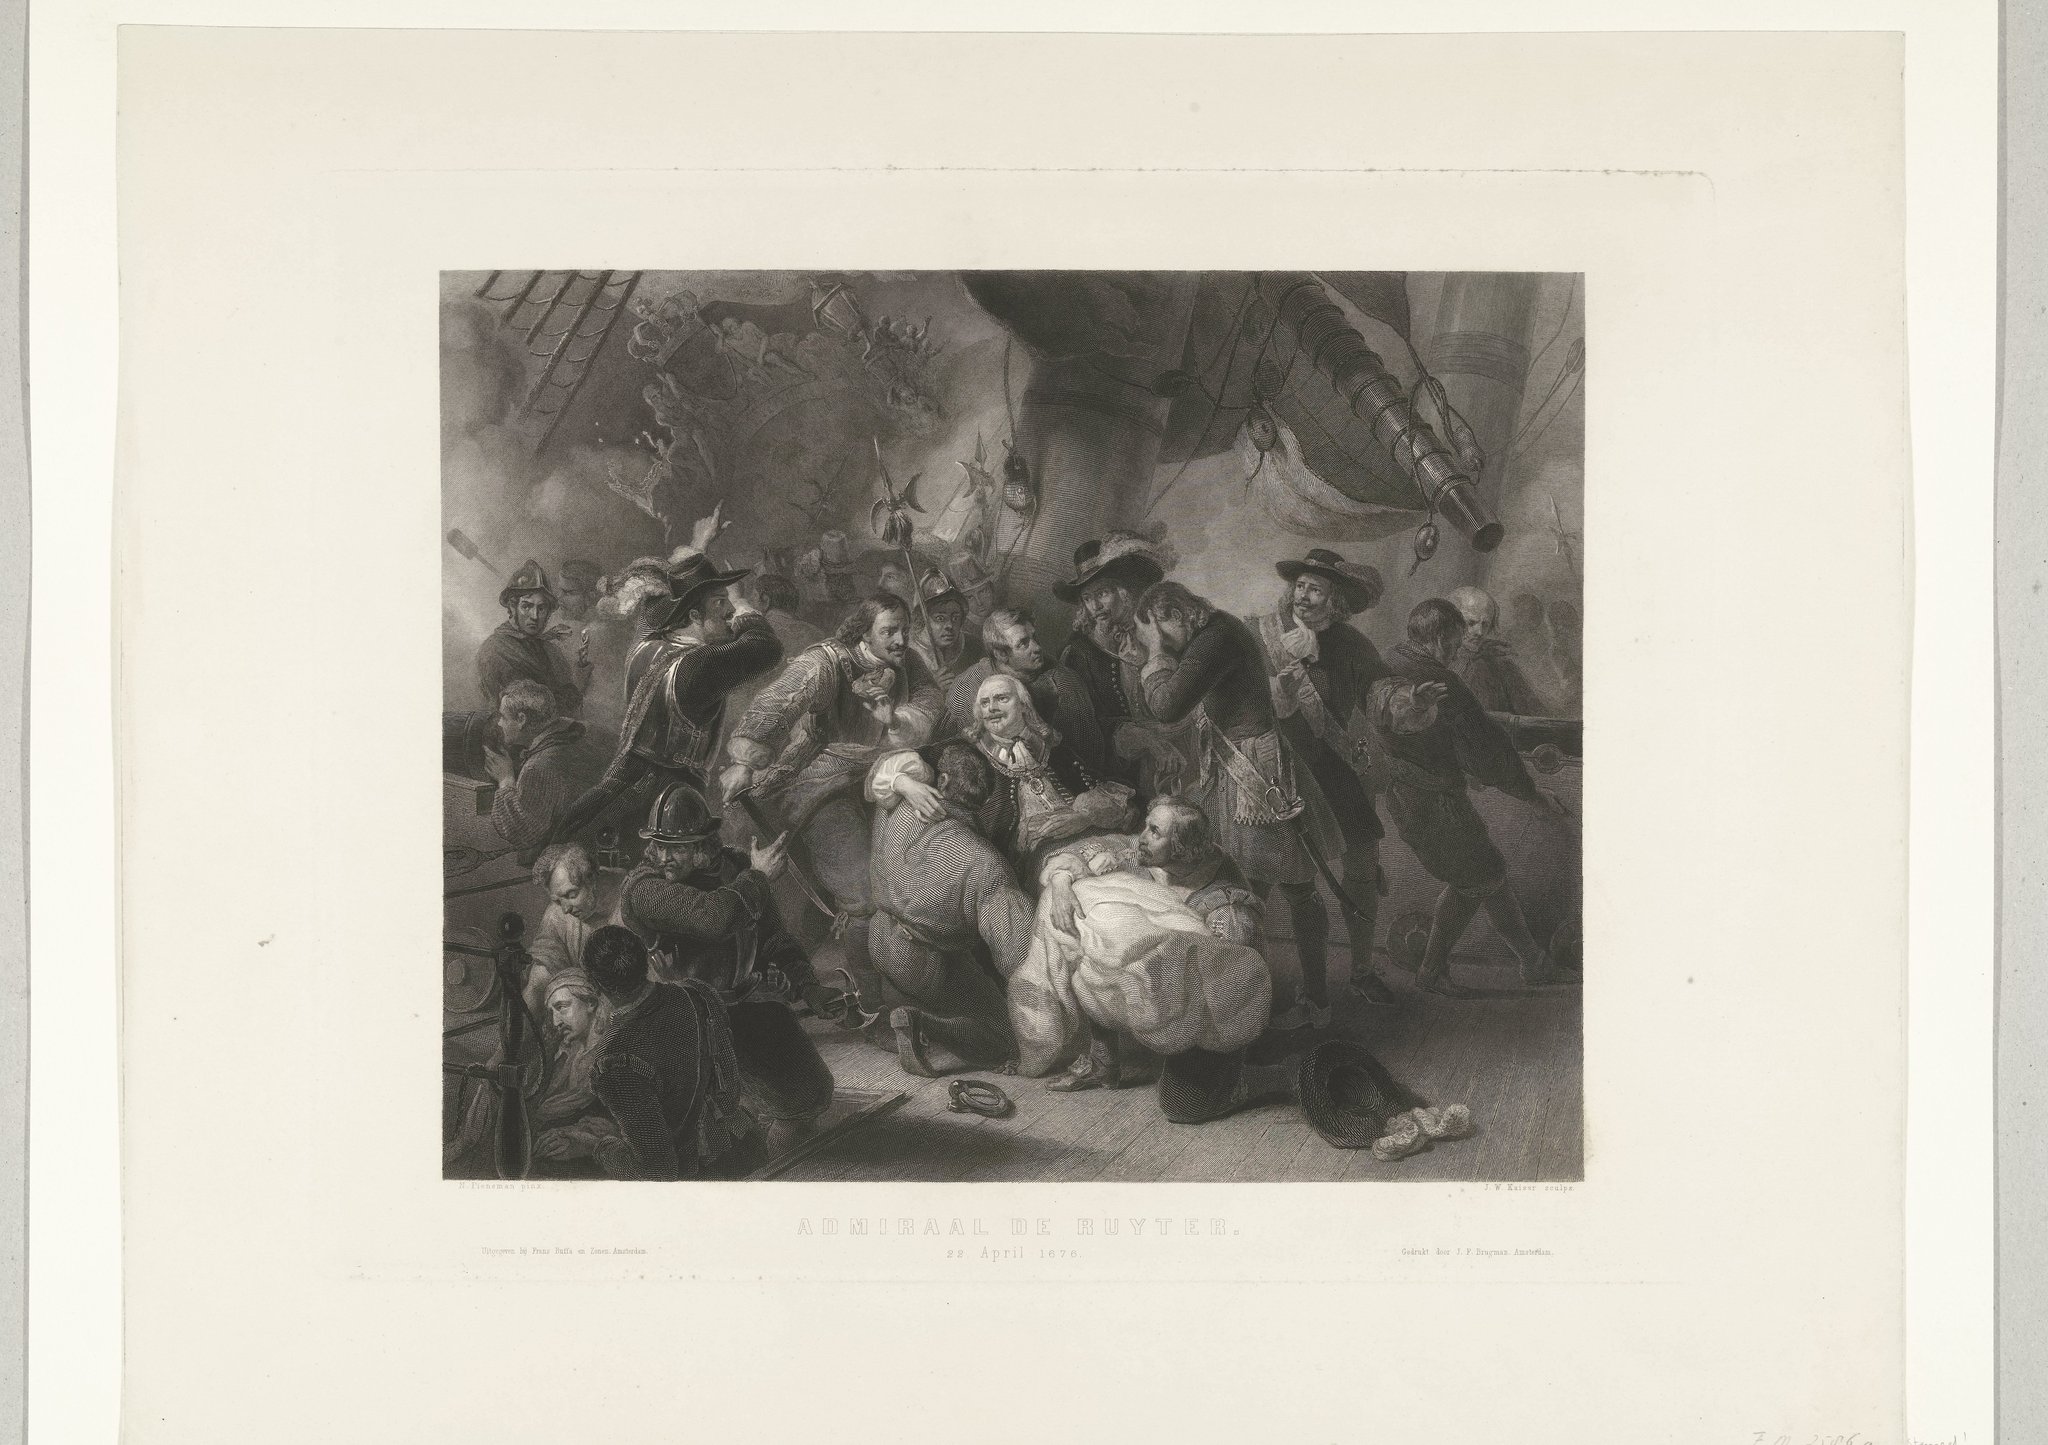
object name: print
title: Admiraal Michiel Adriaenszoon de Ruyter raakt tijdens de zeeslag bij Agosta dodelijk gewond, 1676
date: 1845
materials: paper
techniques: engraving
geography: amsterdam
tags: flushing, michiel adriaenszoon de ruyter, medical aid and nursing of the sick and wounded, battle (+ naval force), battle of augusta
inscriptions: collector's mark: Lugt 12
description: Admiraal Michiel Adriaenszoon de Ruyter raakt dodelijk gewond tijdens de zeeslag bij Agosta op 22 april 1676 tussen een gecombineerd Hollands-Spaanse vloot onder De Ruyter en een Franse vloot onder Abraham Duquesne. In alle hevigheid van de slag wordt De Ruyter wordt door zijn bemanning in een laken gewikkeld en naar zijn kajuit gedragen.